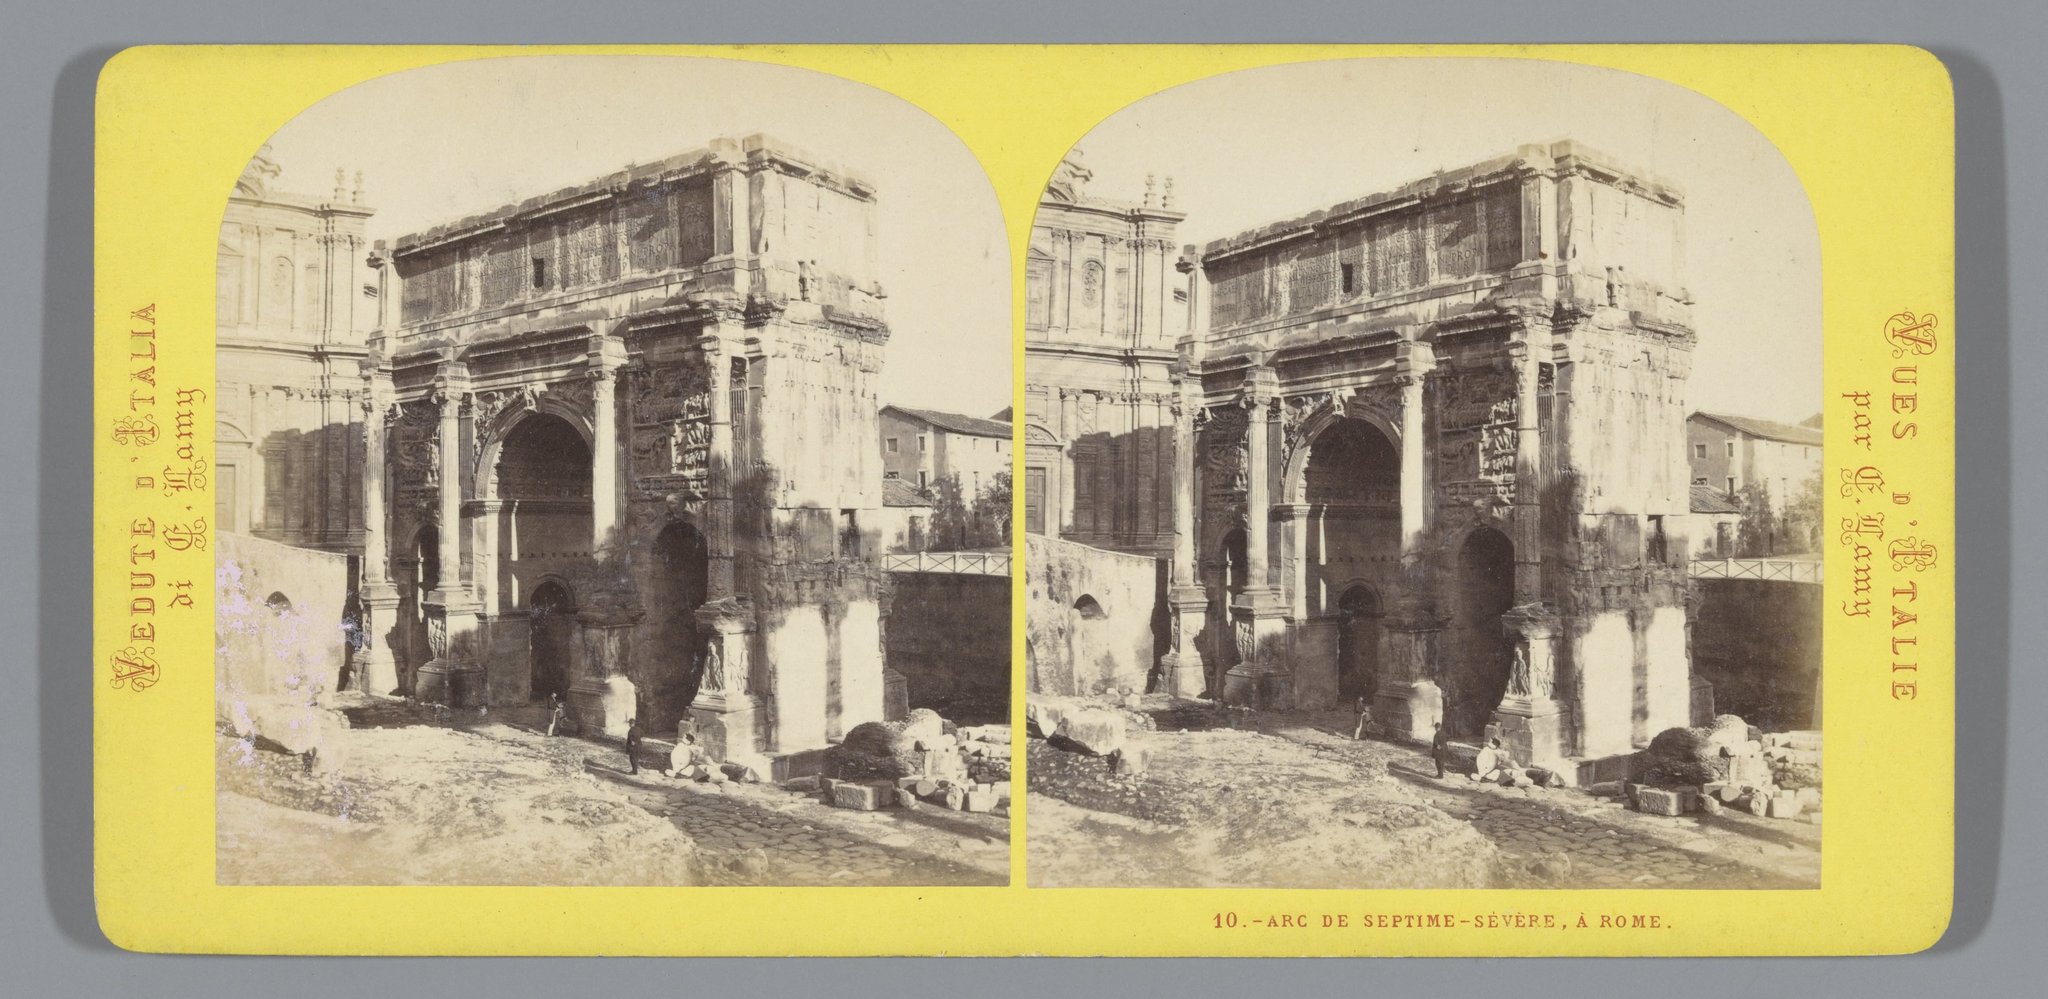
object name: stereograph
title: Arc de Septime-Sévère, à Rome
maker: ernest eléonor pierre lamy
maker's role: publisher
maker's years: 1828-1900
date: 1861-1878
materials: cardboard, paper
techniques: albumen print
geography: rome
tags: triumphal arch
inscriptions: number: ‘10.’